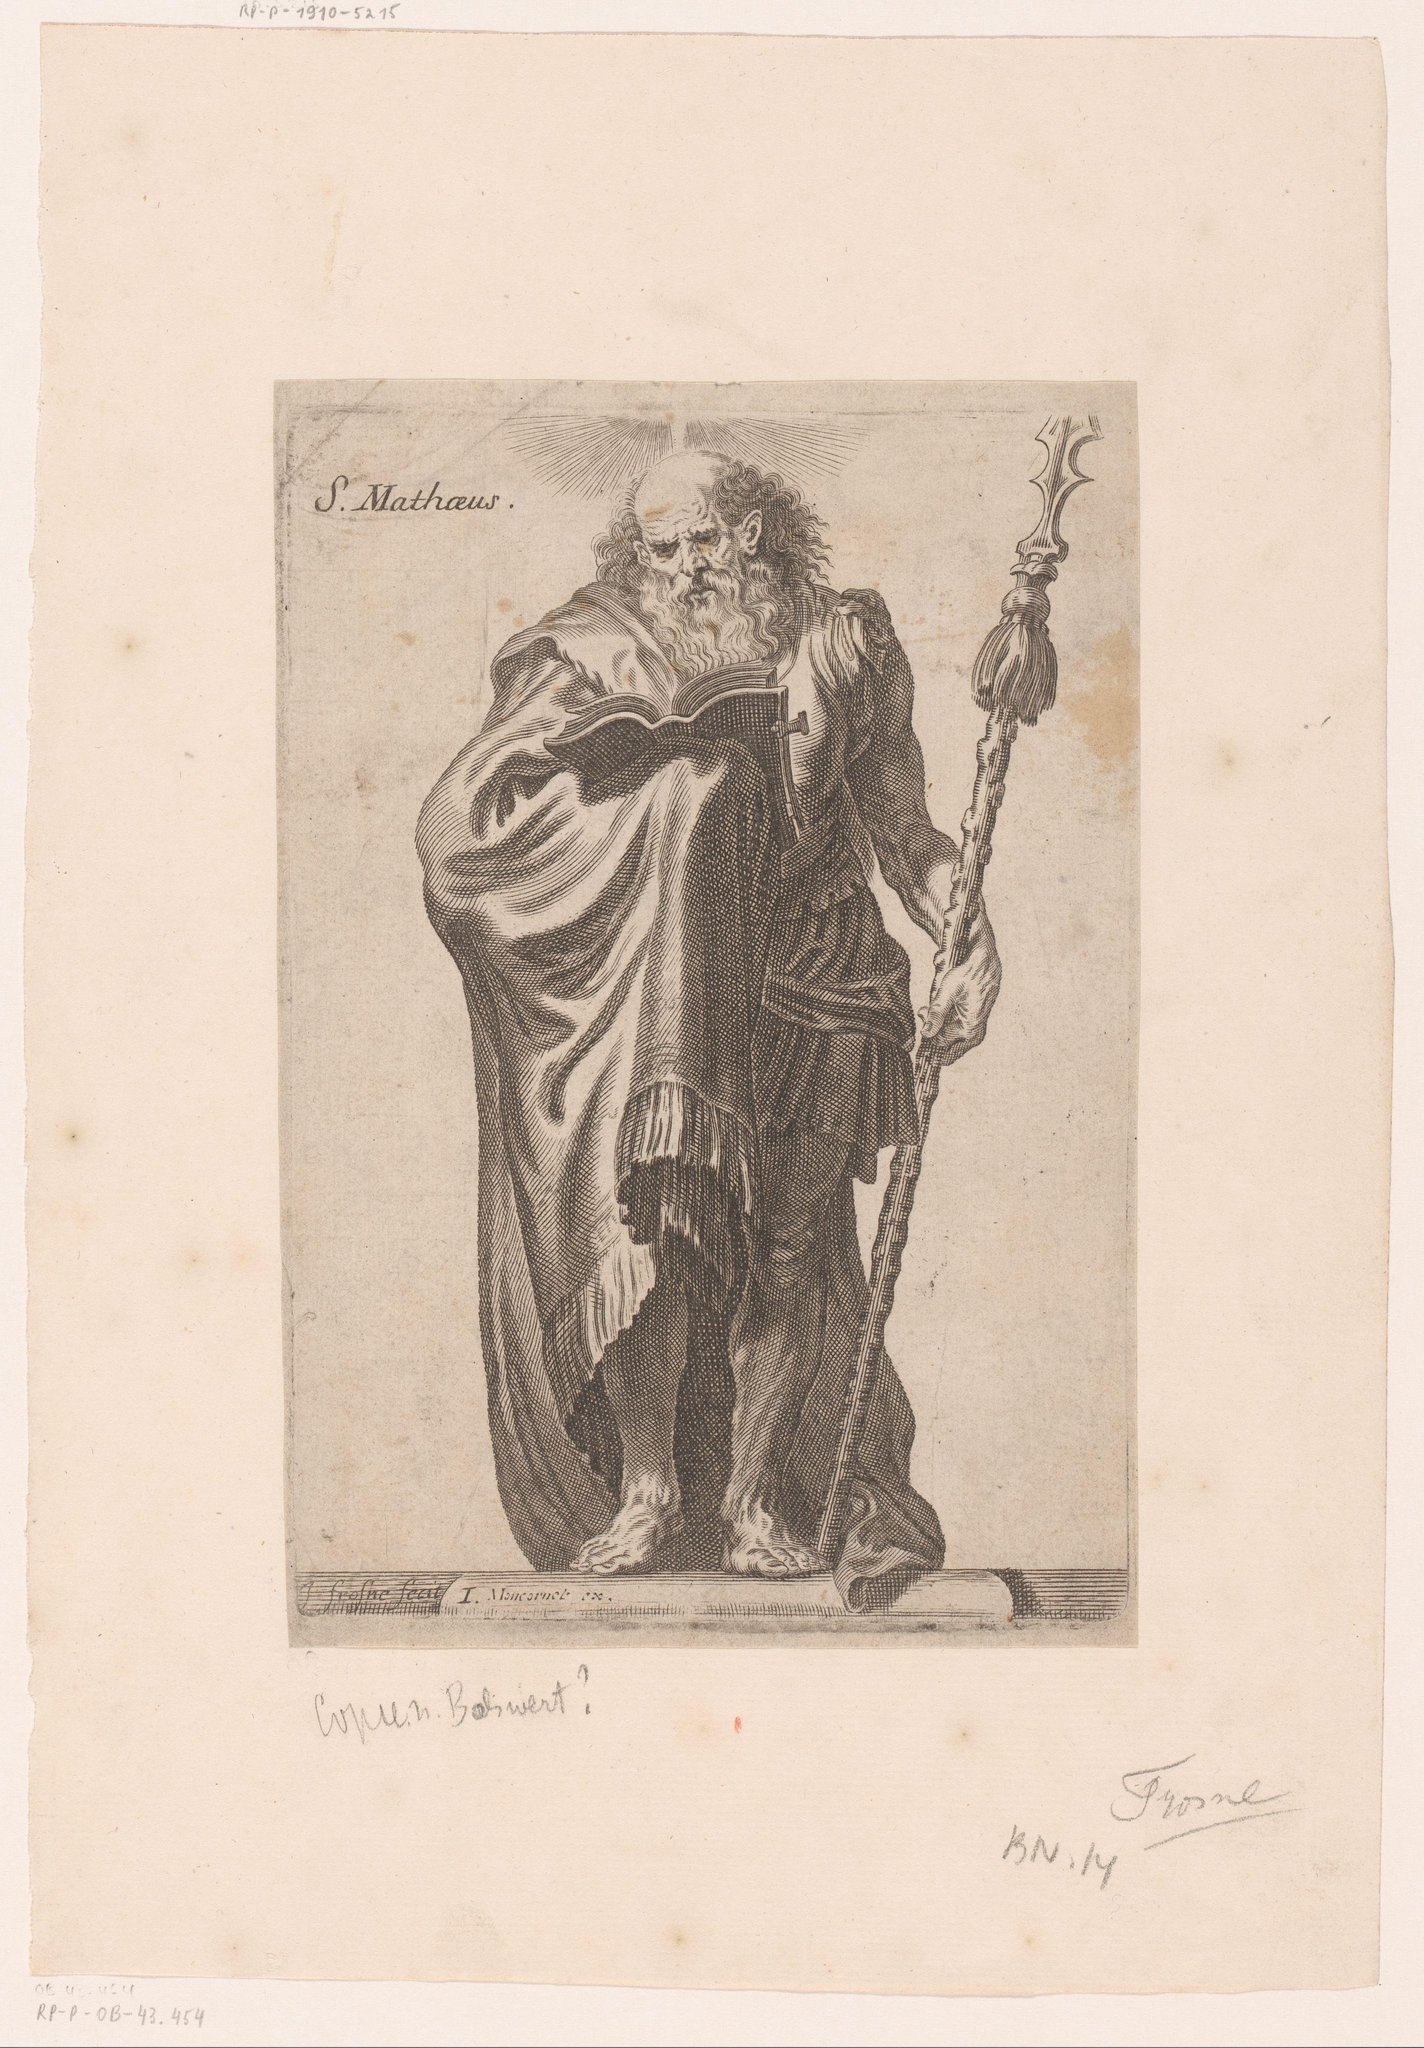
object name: print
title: H. Matteüs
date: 1633-1676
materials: paper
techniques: engraving, etching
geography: paris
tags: life and acts of matthew (levi)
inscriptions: collector's mark: Lugt 2228